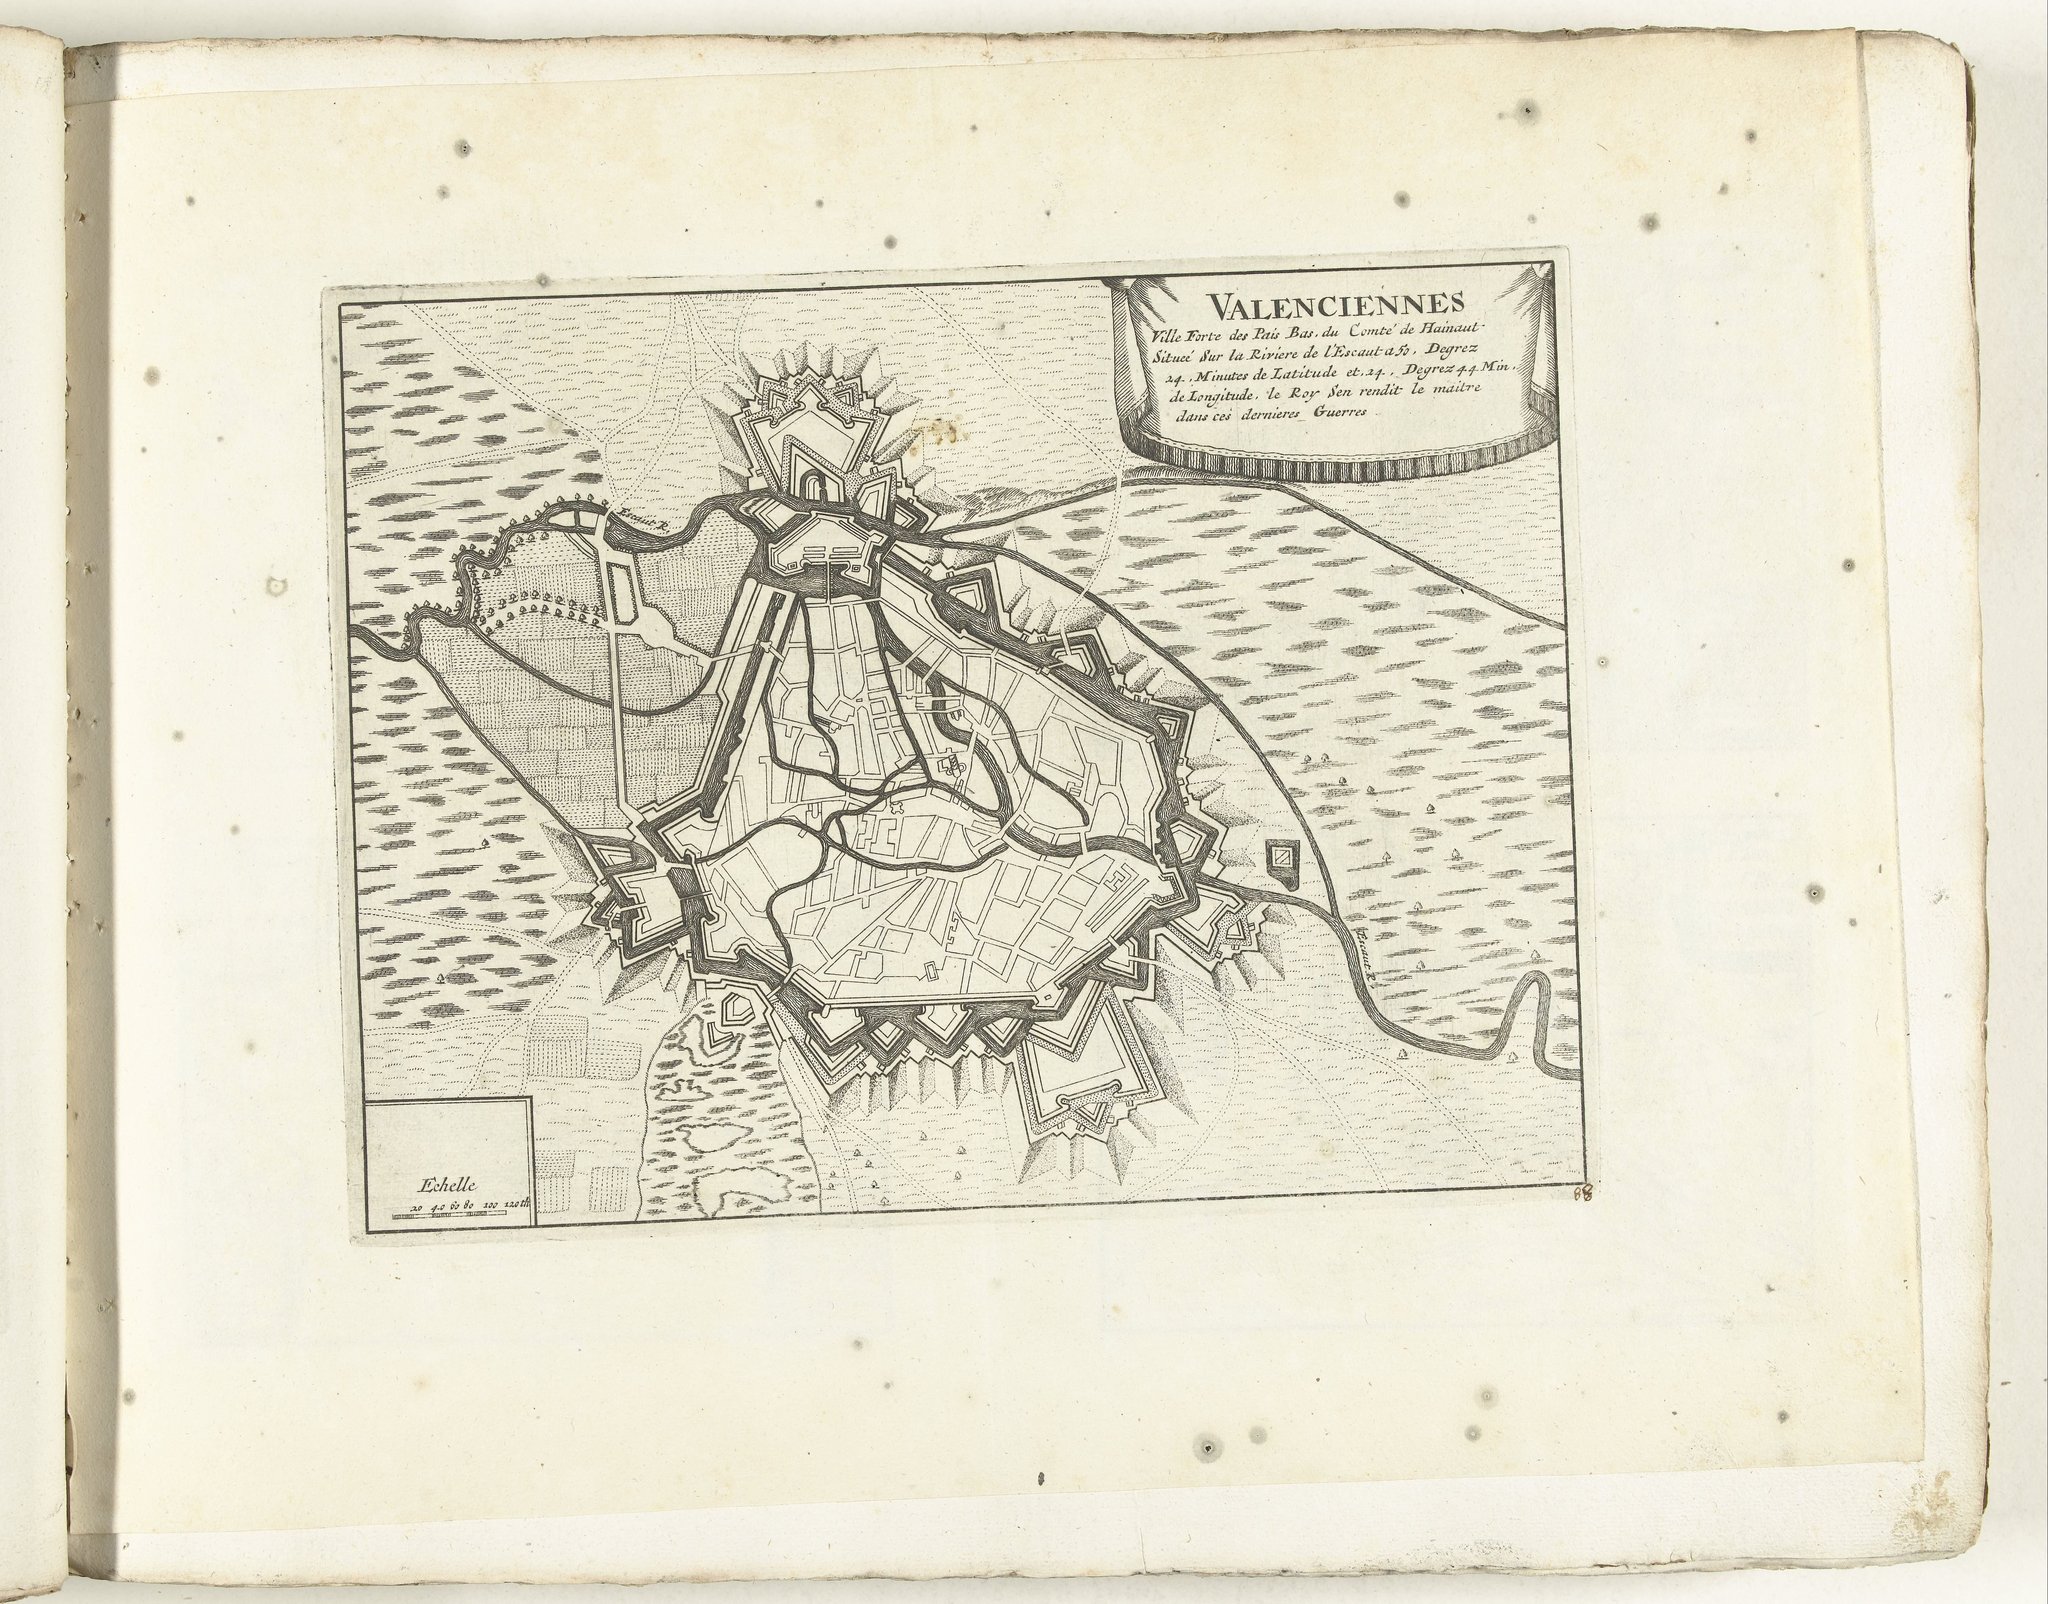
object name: print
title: Valenciennes Ville Forte des Pais Bas, du Comté de Hainaut (...)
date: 1702-1703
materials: paper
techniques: etching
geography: amsterdam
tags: fortress, maps of cities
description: Plattegrond van de versterkingen om de stad Valenciennes. Plaat nr. 88 in het prentwerk bestaande in totaal uit 276 genummerde platen van vermaarde sterke steden en vestingen in het kader van de Spaanse Successieoorlog. Voor het merendeel zijn deze platen gekopieerd naar de anonieme Franse platen: in Les forces de l'Europe en in: Le theatre de la guerre, dans les Pays-Bas, beide oorspronkelijk uitgegeven door Nicolas de Fer te Parijs (1693-1697) in het kader van de Negenjarige Oorlog. Titel en opschriften in de plaat in het Frans.